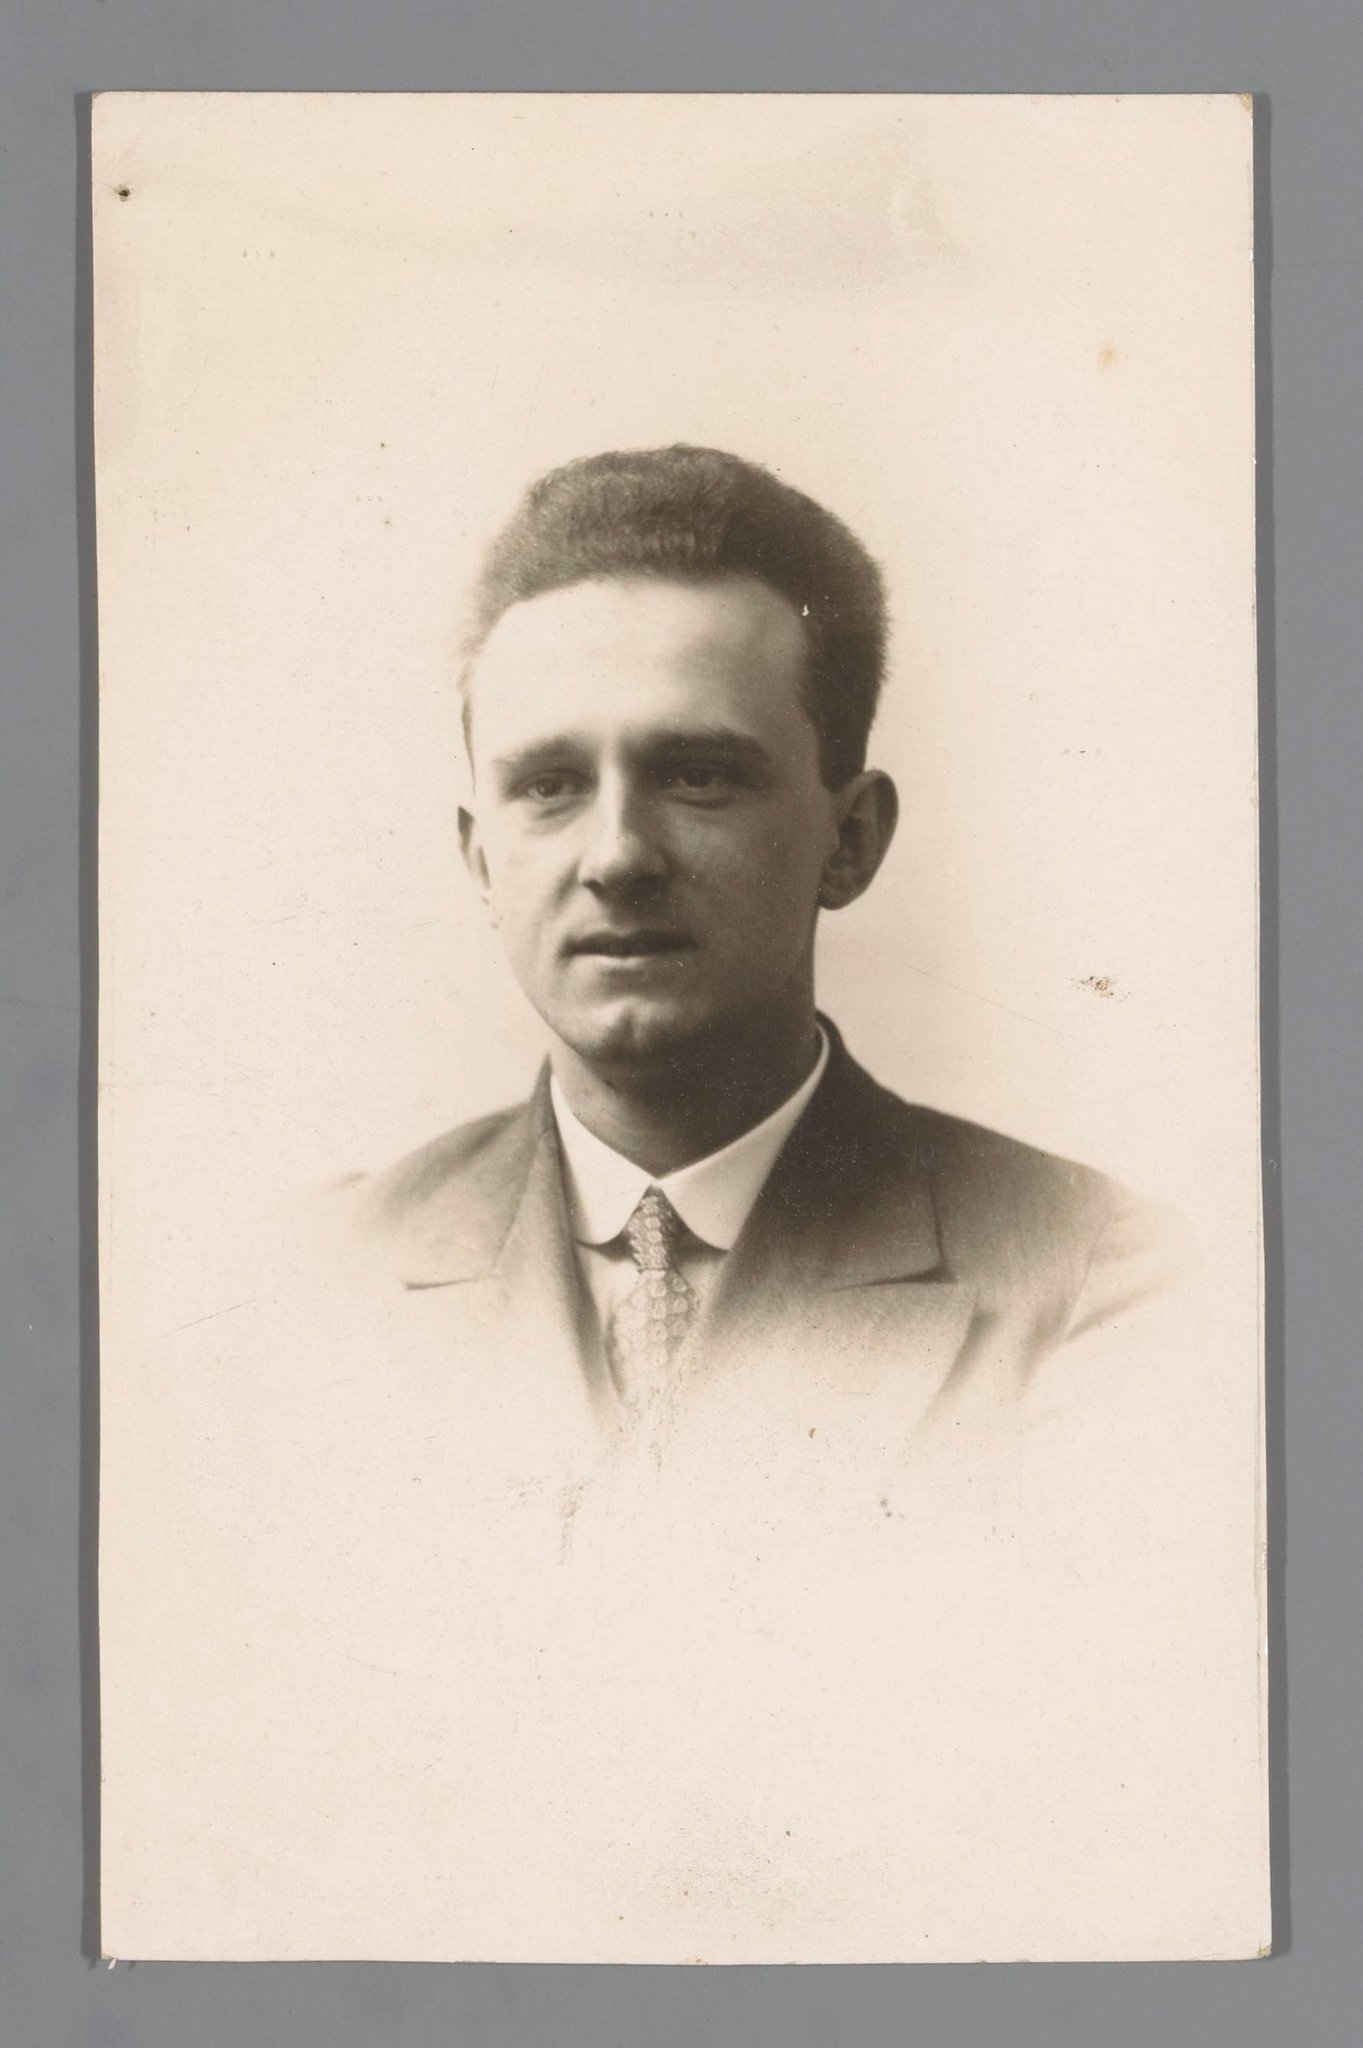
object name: photograph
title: Portret van een onbekende man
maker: Anonymous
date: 1860-1900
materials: photographic support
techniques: gelatin silver print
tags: adult man